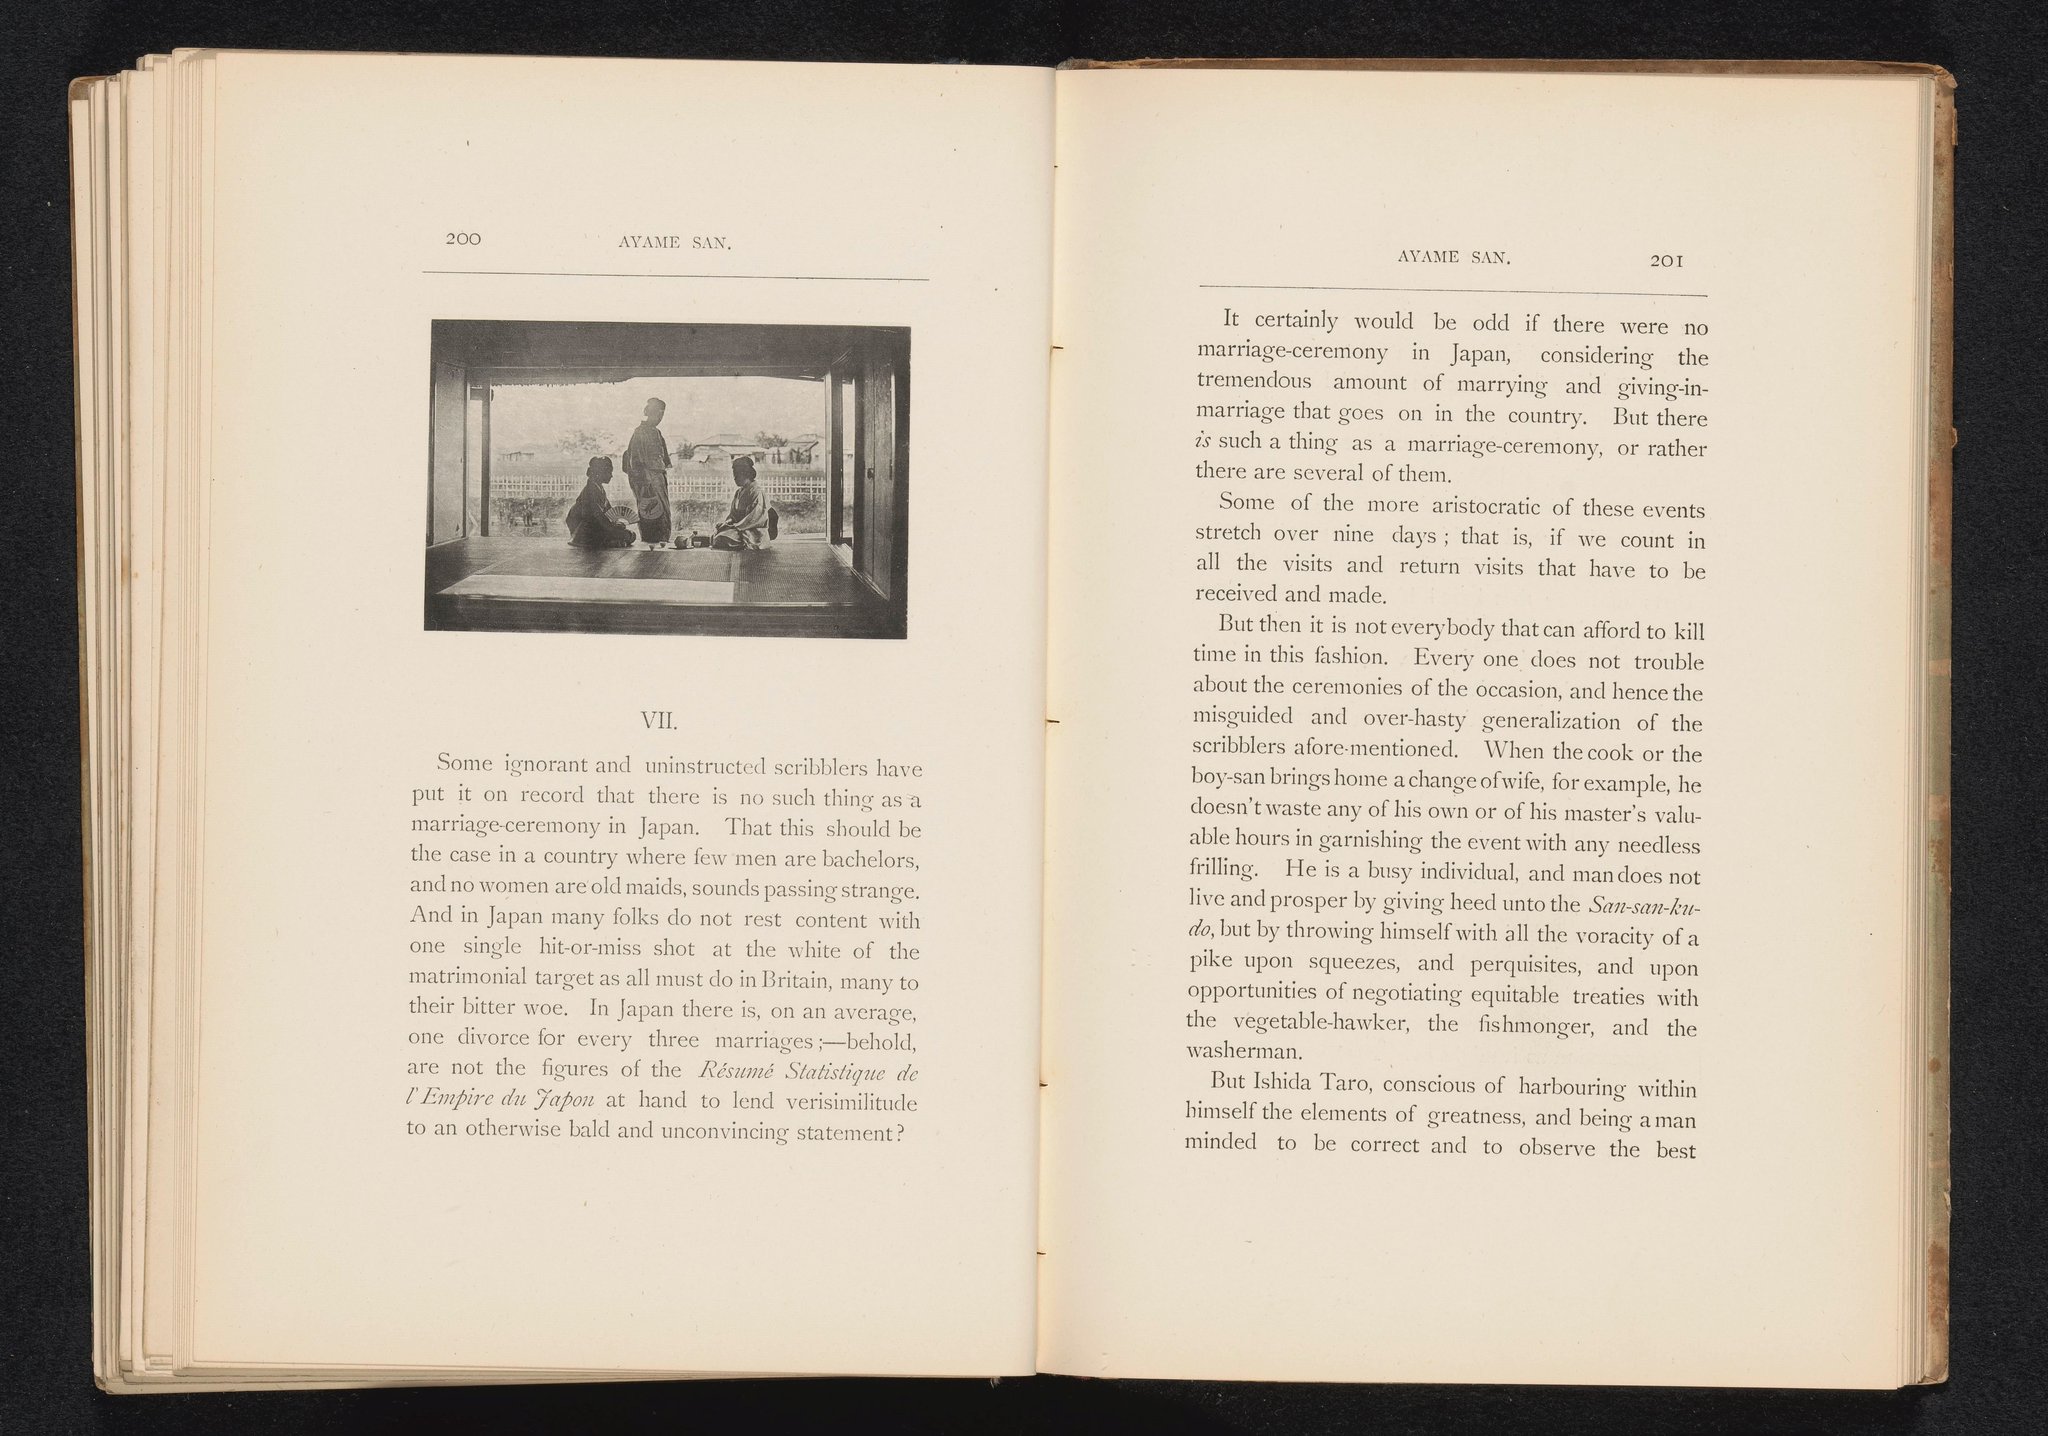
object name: page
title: Drie zittende vrouwen in een woonhuis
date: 1882-1892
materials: paper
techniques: photograph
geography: japan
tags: sitting figure, interior ~ representation of a building